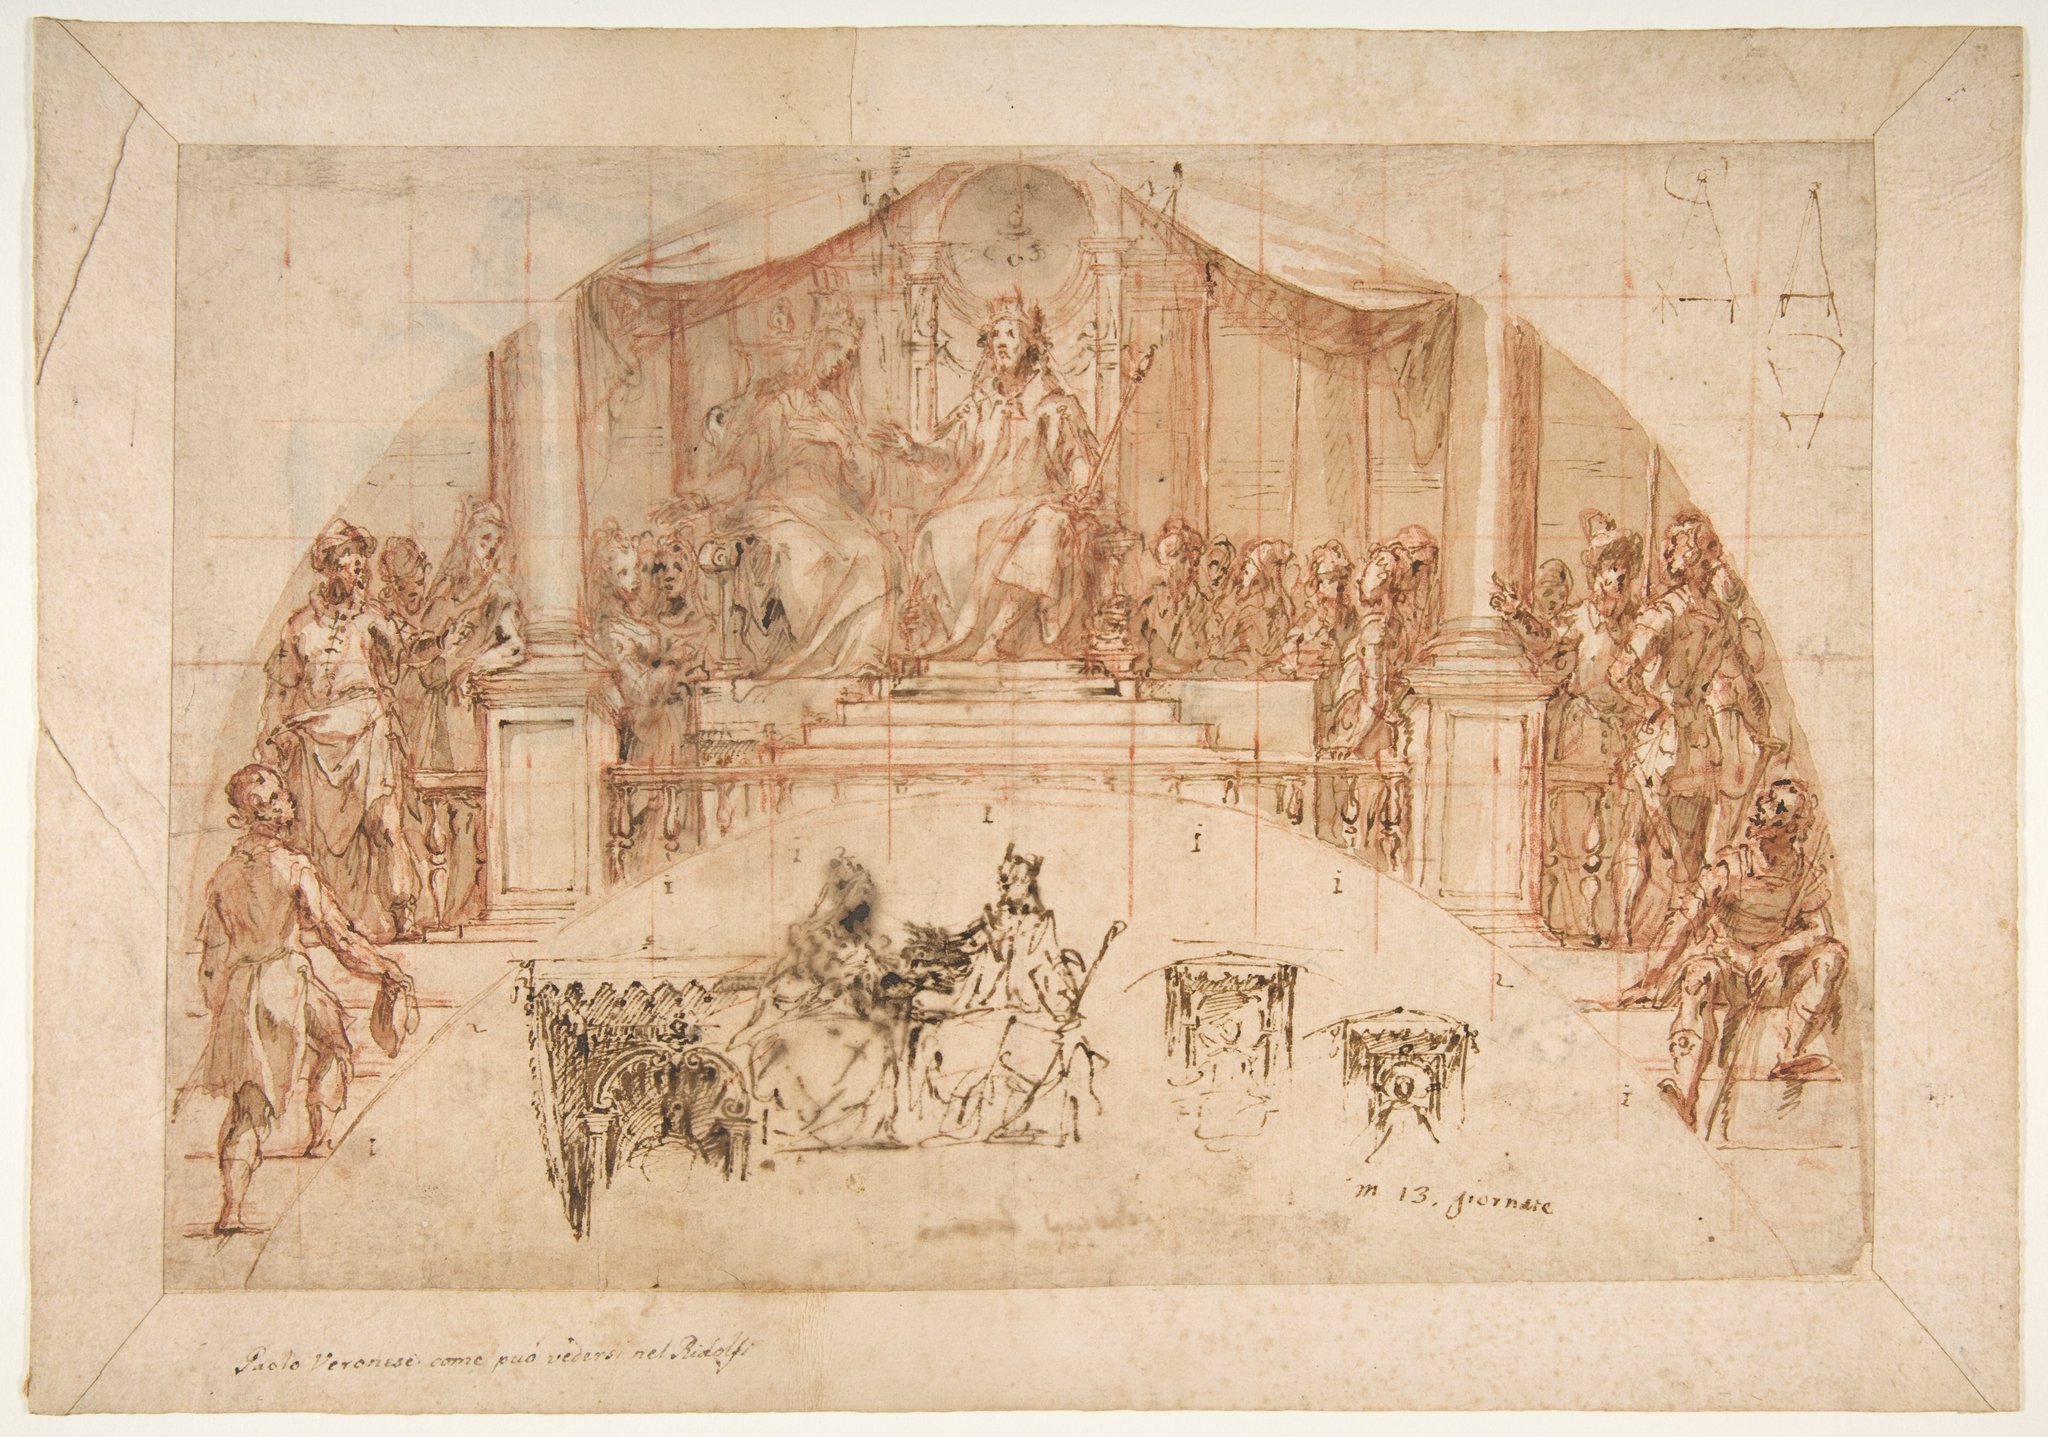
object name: drawing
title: The Coronation of Esther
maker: carlo urbino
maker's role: artist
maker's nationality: italian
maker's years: 1505-1605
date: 1510-1585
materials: chalk, ink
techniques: pen, drawing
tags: men,women,ceremony